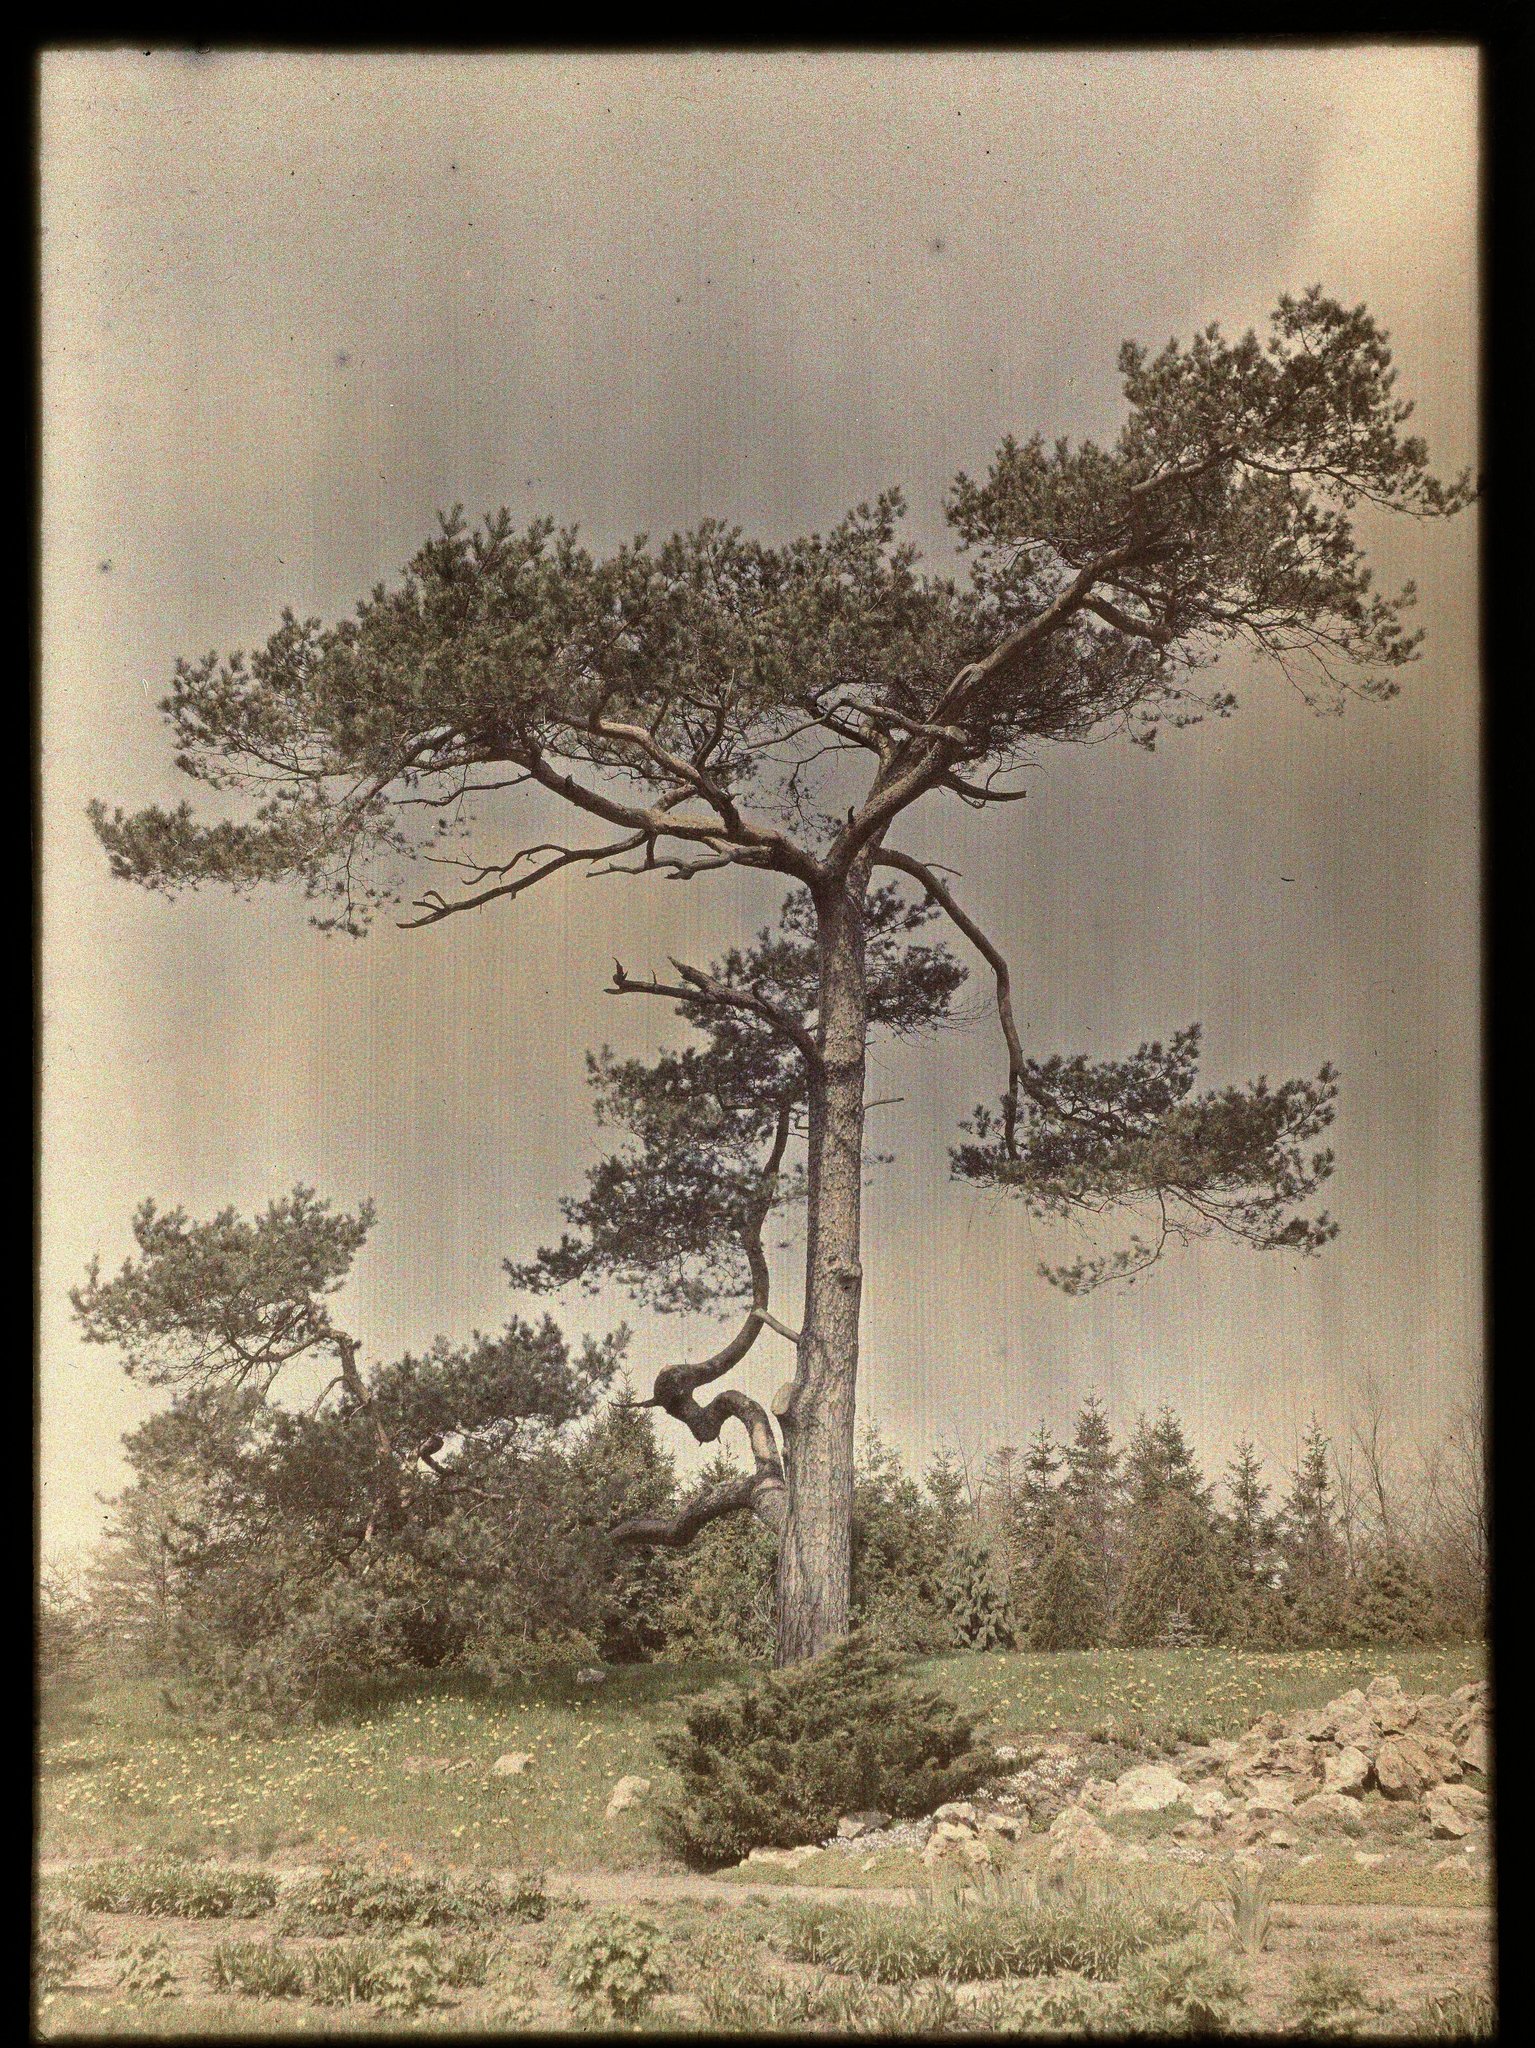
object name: color slide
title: Boom in een veld met gele bloemen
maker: adolphe burdet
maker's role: fotograaf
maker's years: 1860-1940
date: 1907-1930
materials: glass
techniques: autochrome process, slide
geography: netherlands